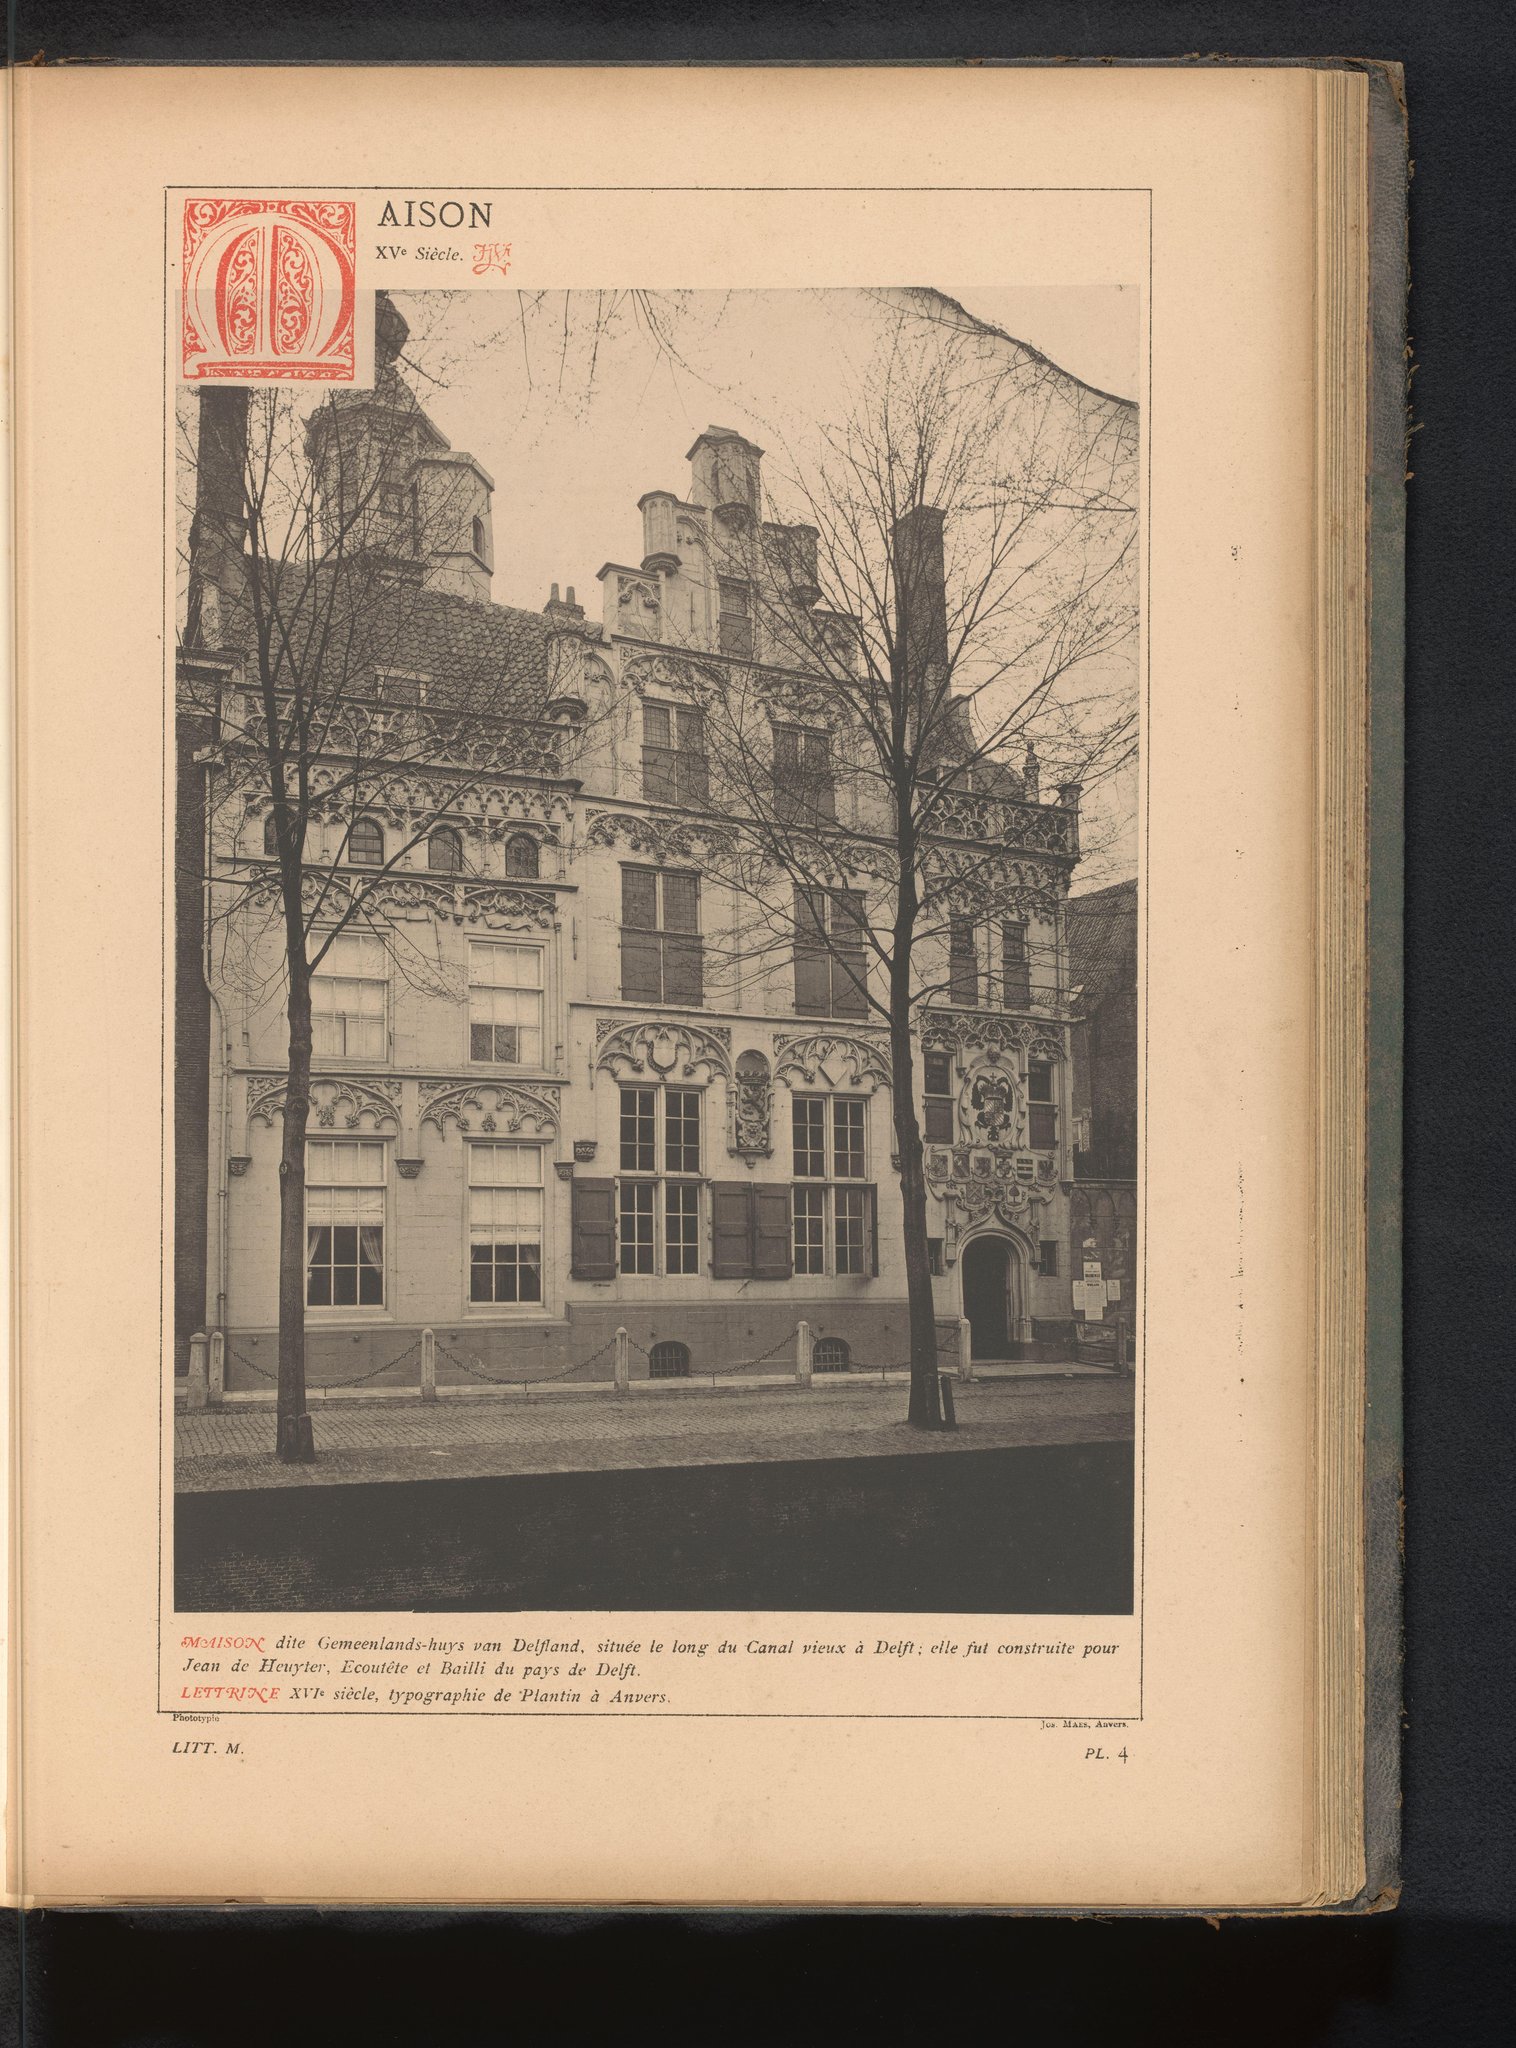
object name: photomechanical print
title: Gezicht op het Gemeenlandshuis in Delft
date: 1875-1880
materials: paper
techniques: photograph, photolithography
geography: antwerp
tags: civic architecture; edifices; dwellings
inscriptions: inscription: ‘LITT. M. - PL. 4’, inscription: ‘MAISON dite Gemeenlands-huys (...)’, monogram: ‘JJvY’